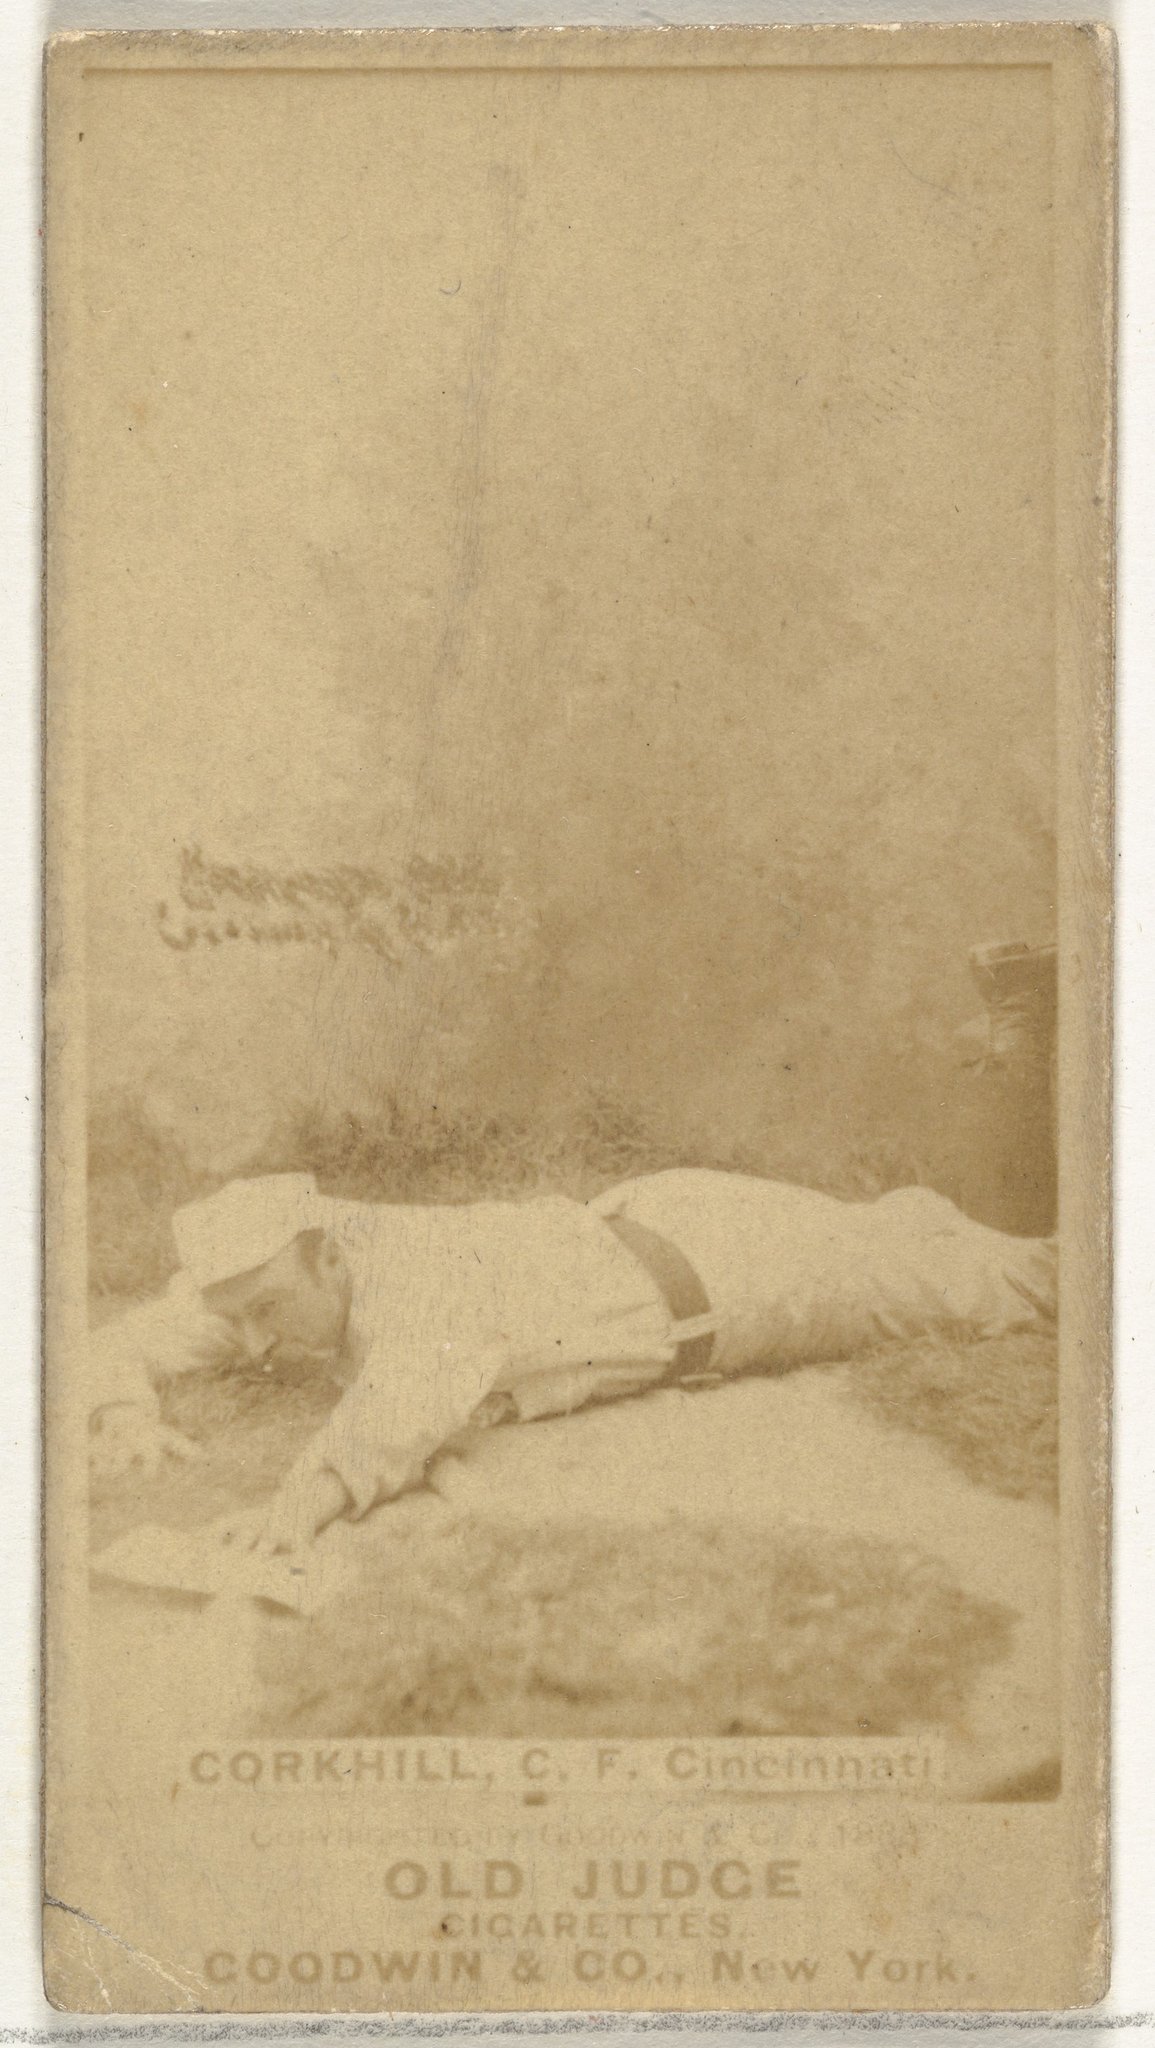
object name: baseball card, photograph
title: John Stewart "Pop" Corkhill, Center Field, Cincinnati, from the Old Judge series (N172) for Old Judge Cigarettes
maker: goodwin & company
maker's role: publisher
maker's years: 1850-1950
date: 1887-1890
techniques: albumen silver print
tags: men,portraits,baseball,athletes